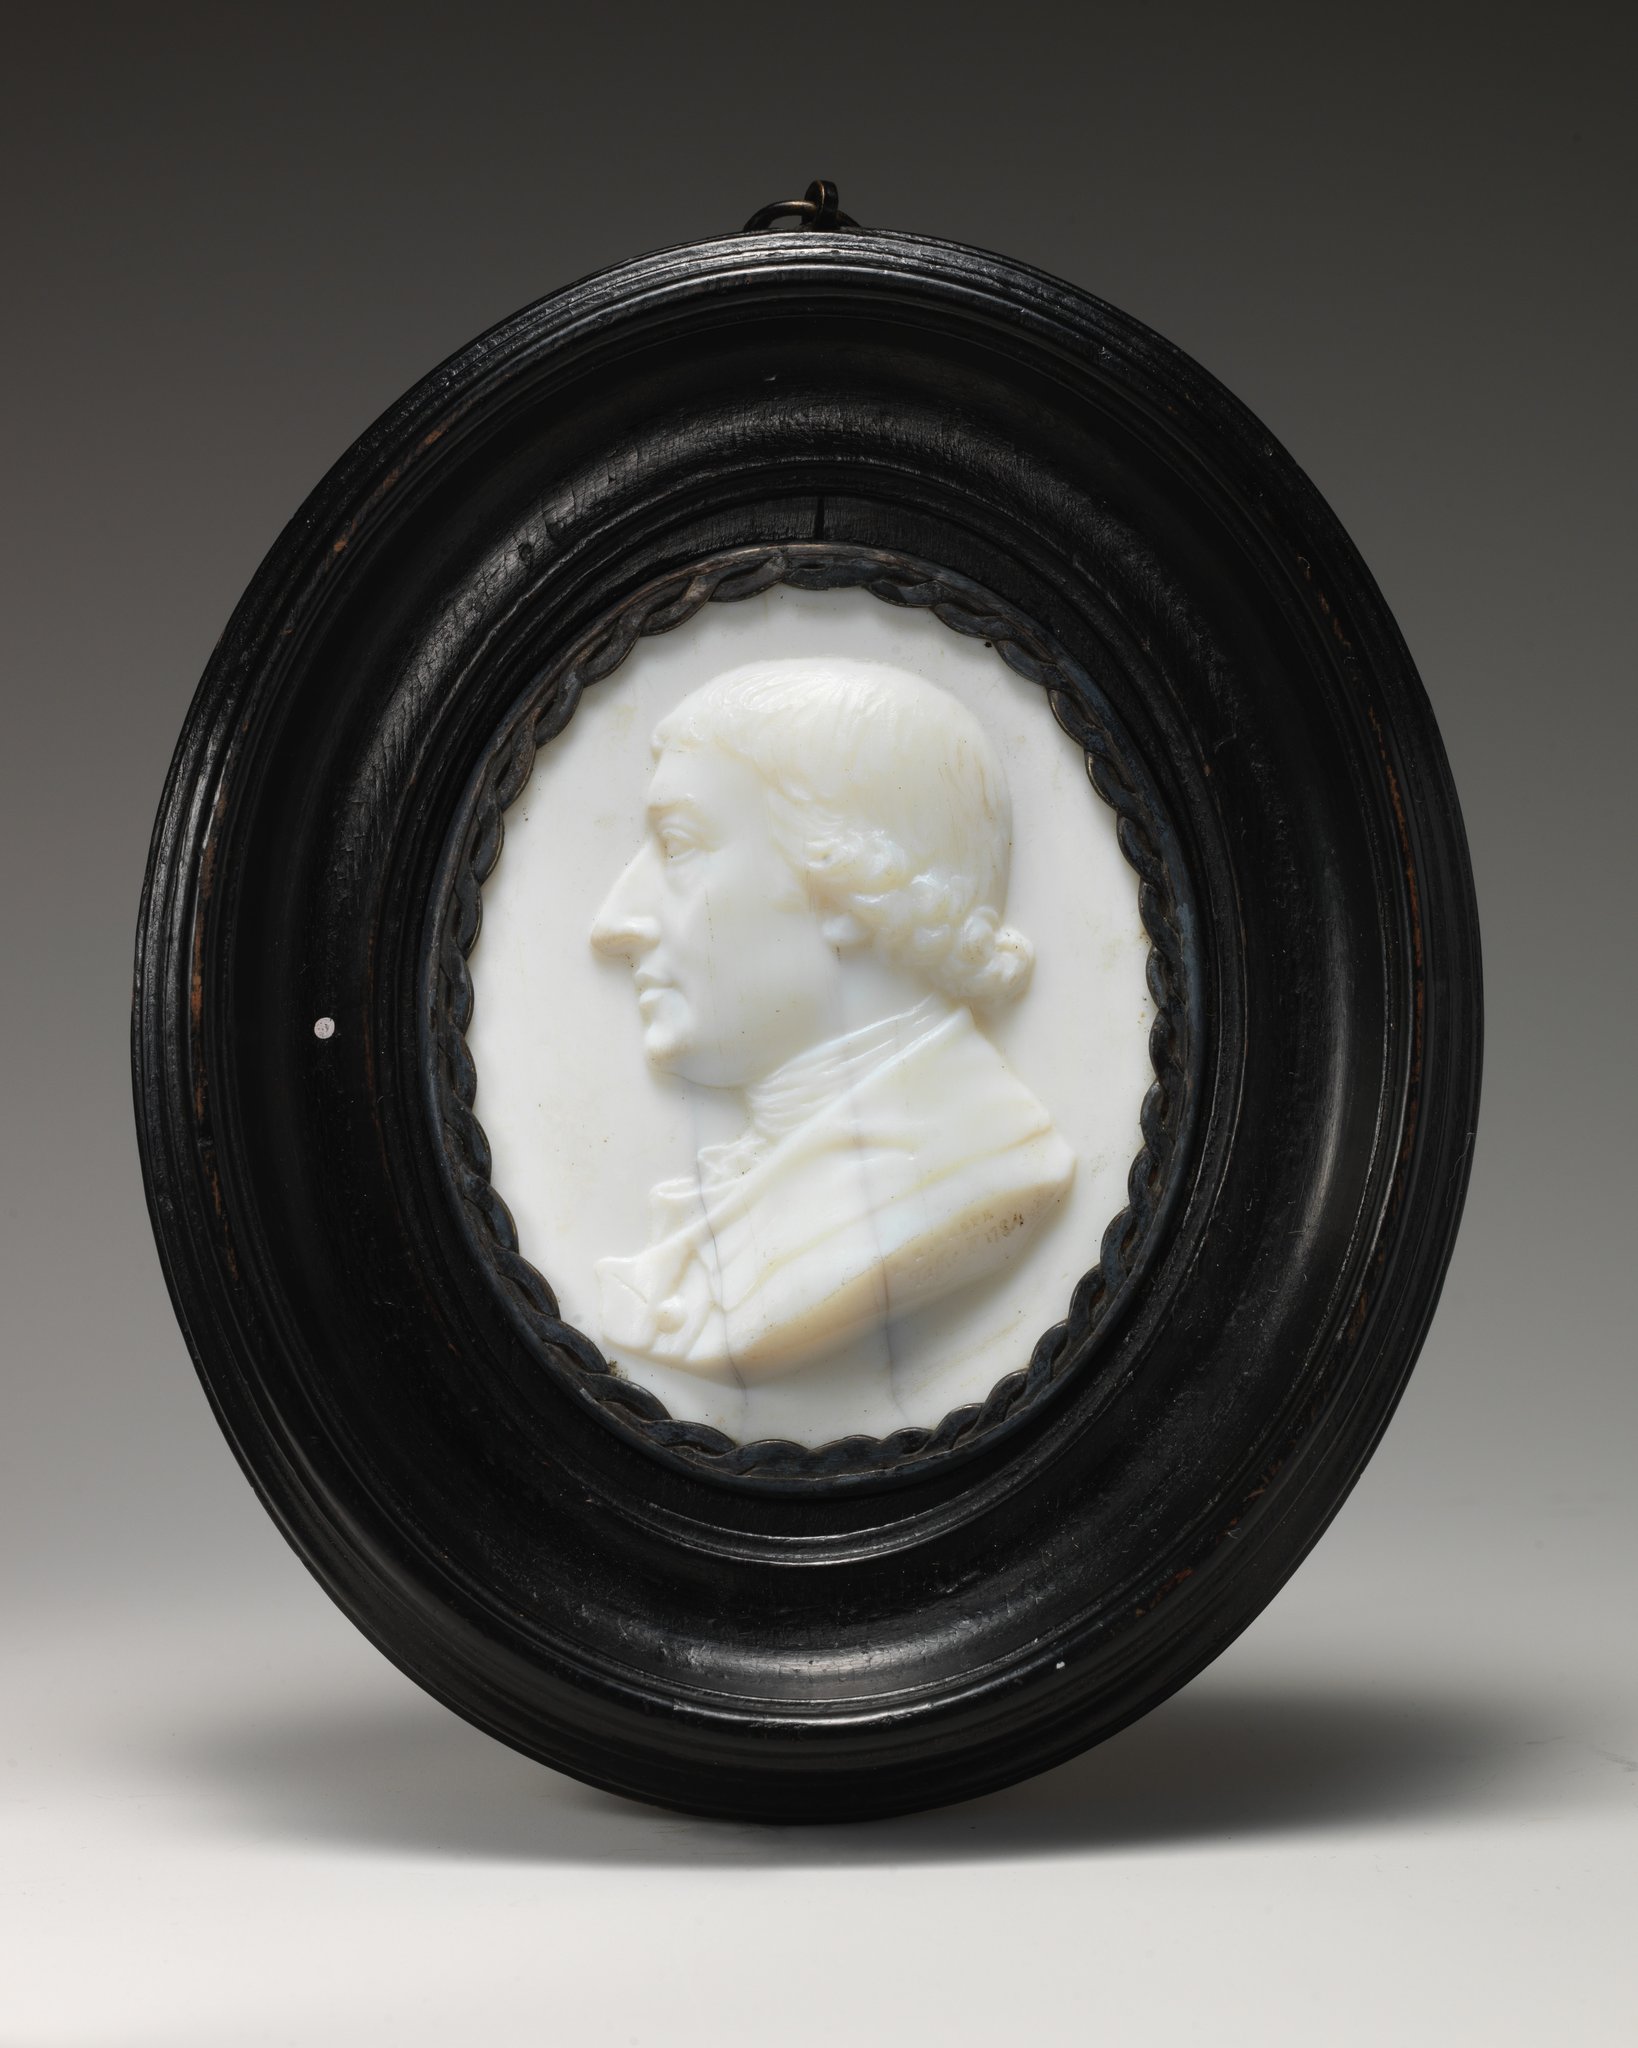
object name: medallion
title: Rudolph Eric Raspe (1737–1794)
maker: james tassie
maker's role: artist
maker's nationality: british, scottish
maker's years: 1735-1799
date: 1784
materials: glass, paste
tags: men,profiles